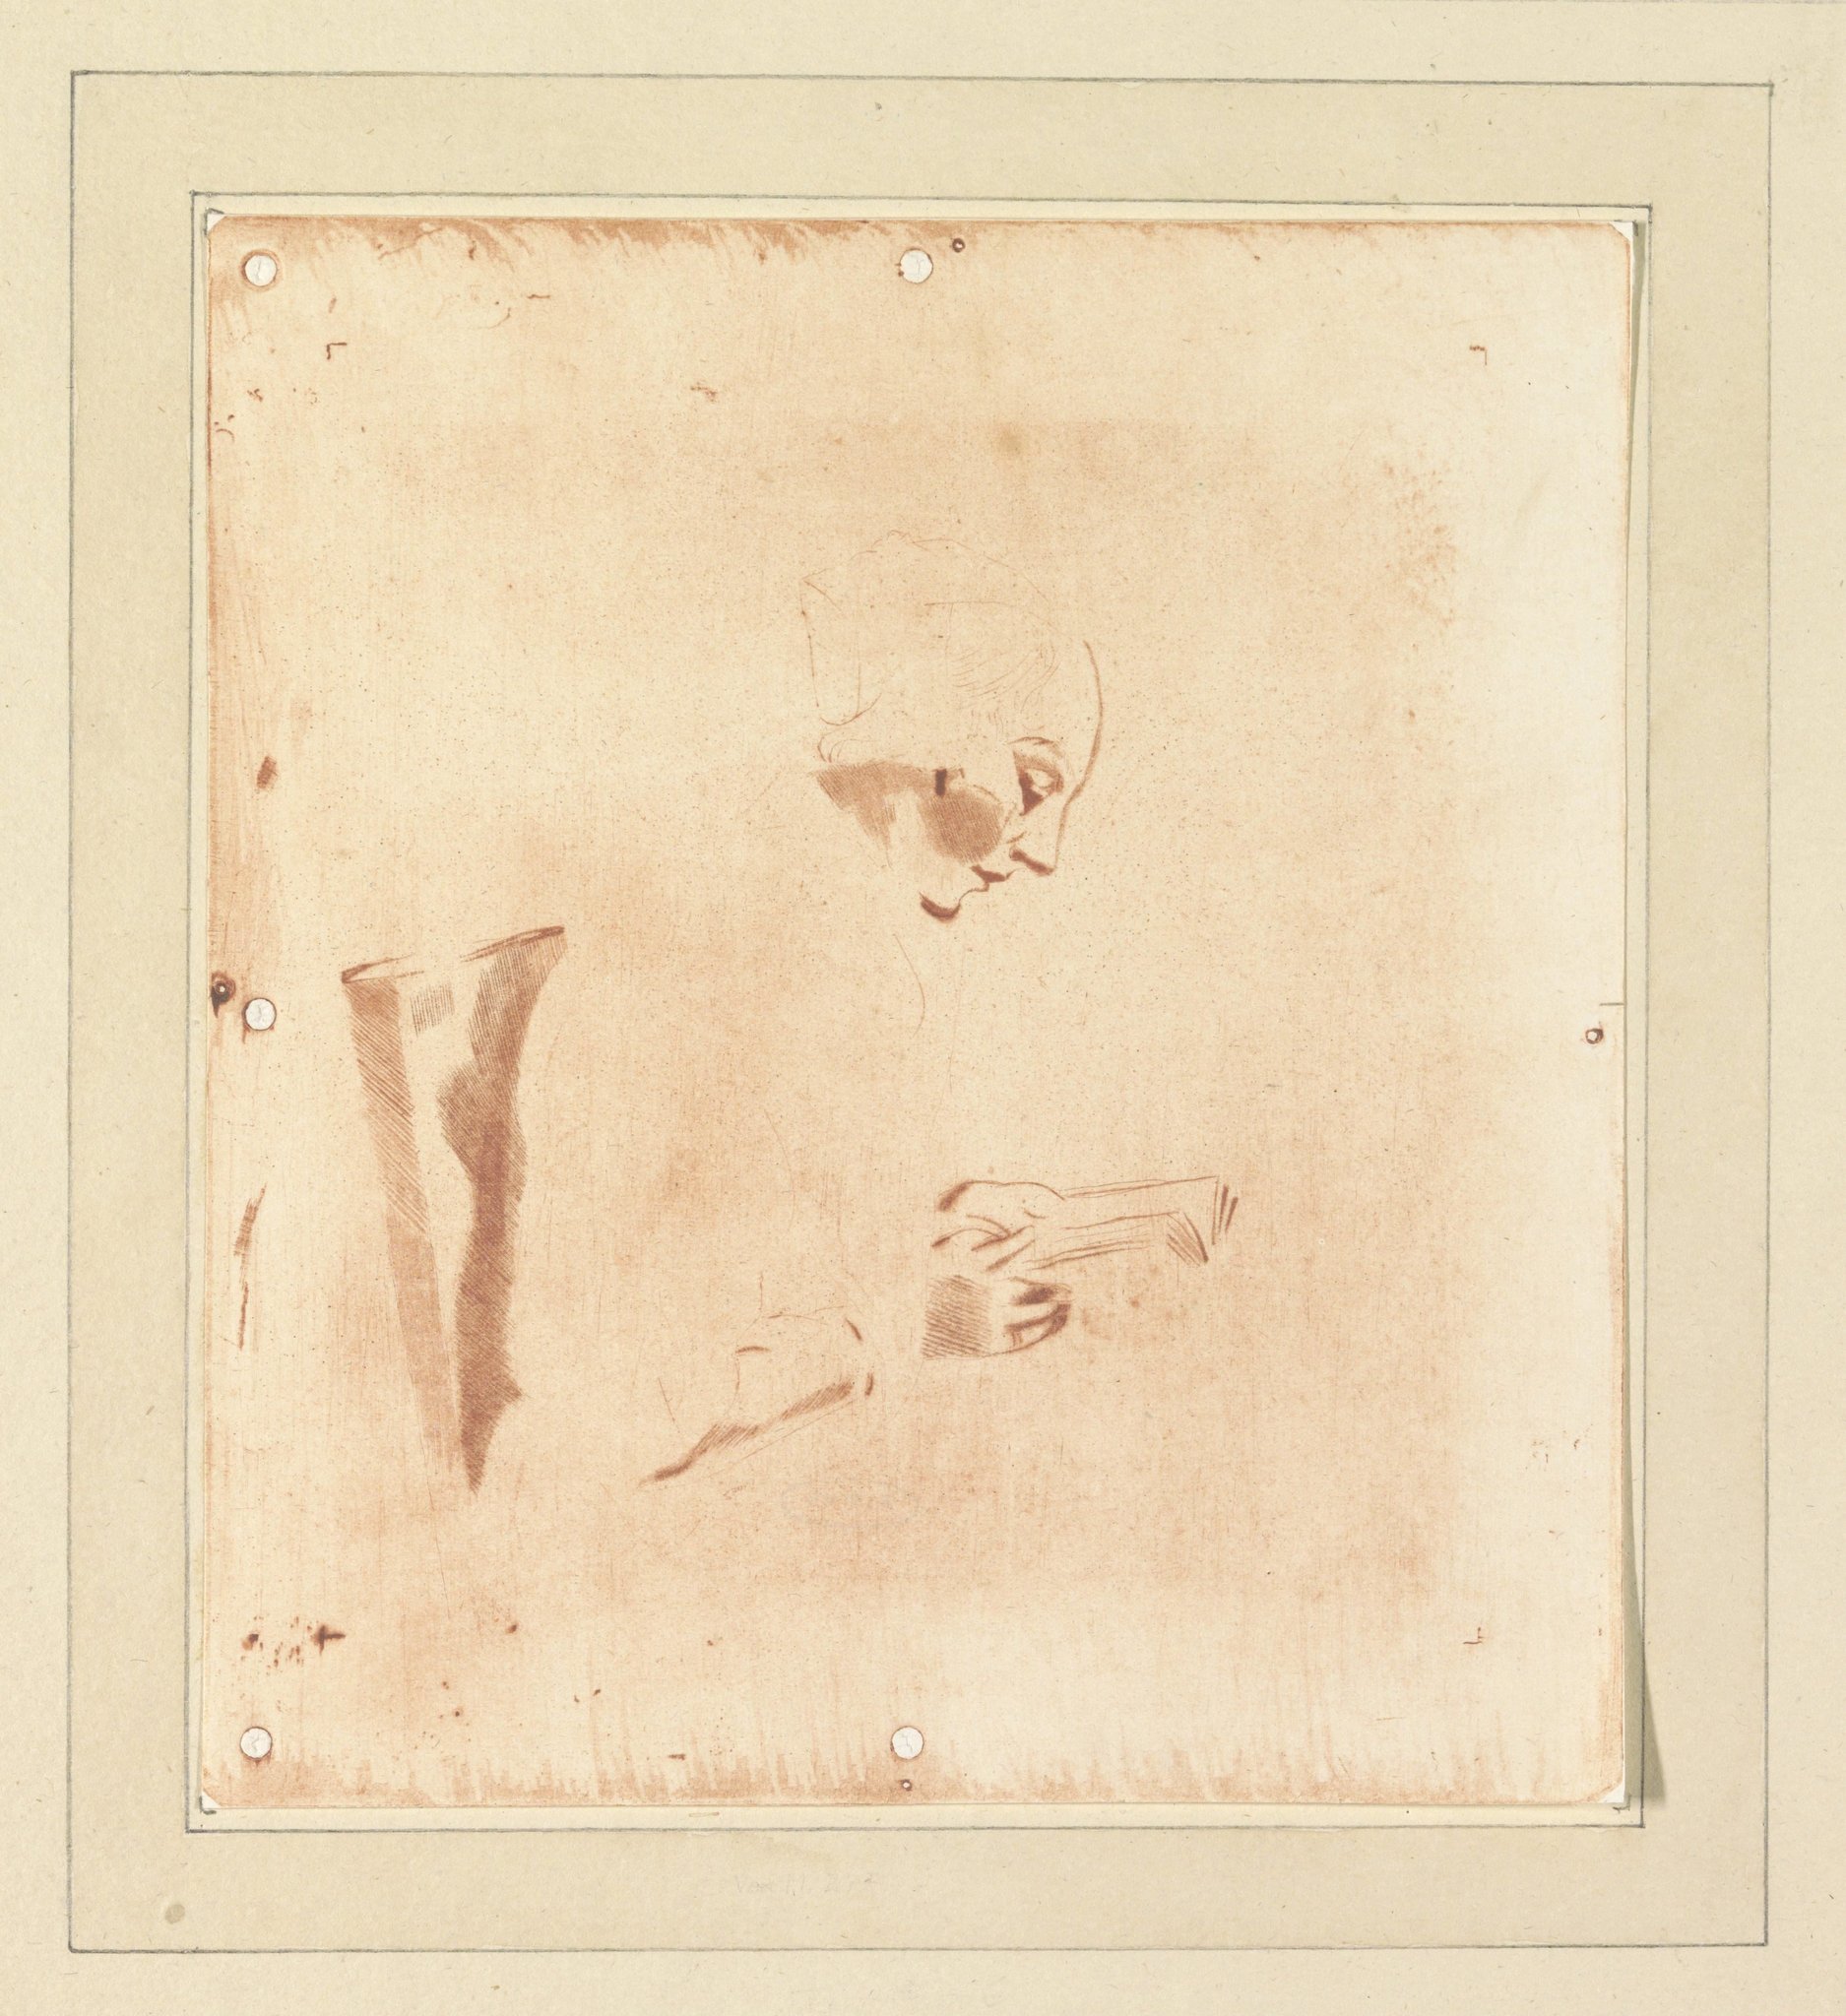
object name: print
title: Lezende vrouw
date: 1736-1738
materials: paper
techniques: printmaking, etching, roulette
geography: amsterdam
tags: reading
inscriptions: collector's mark: Lugt 2228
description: Lezende vrouw, alleen de roodplaat met registergaten.